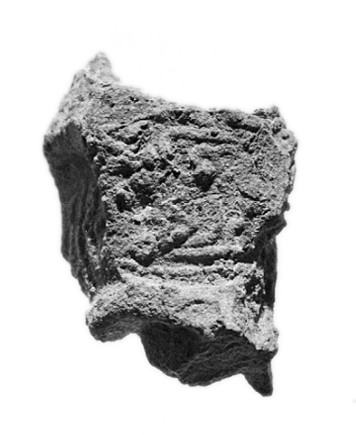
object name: sealing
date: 1981-1640 BCE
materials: mud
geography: egypt